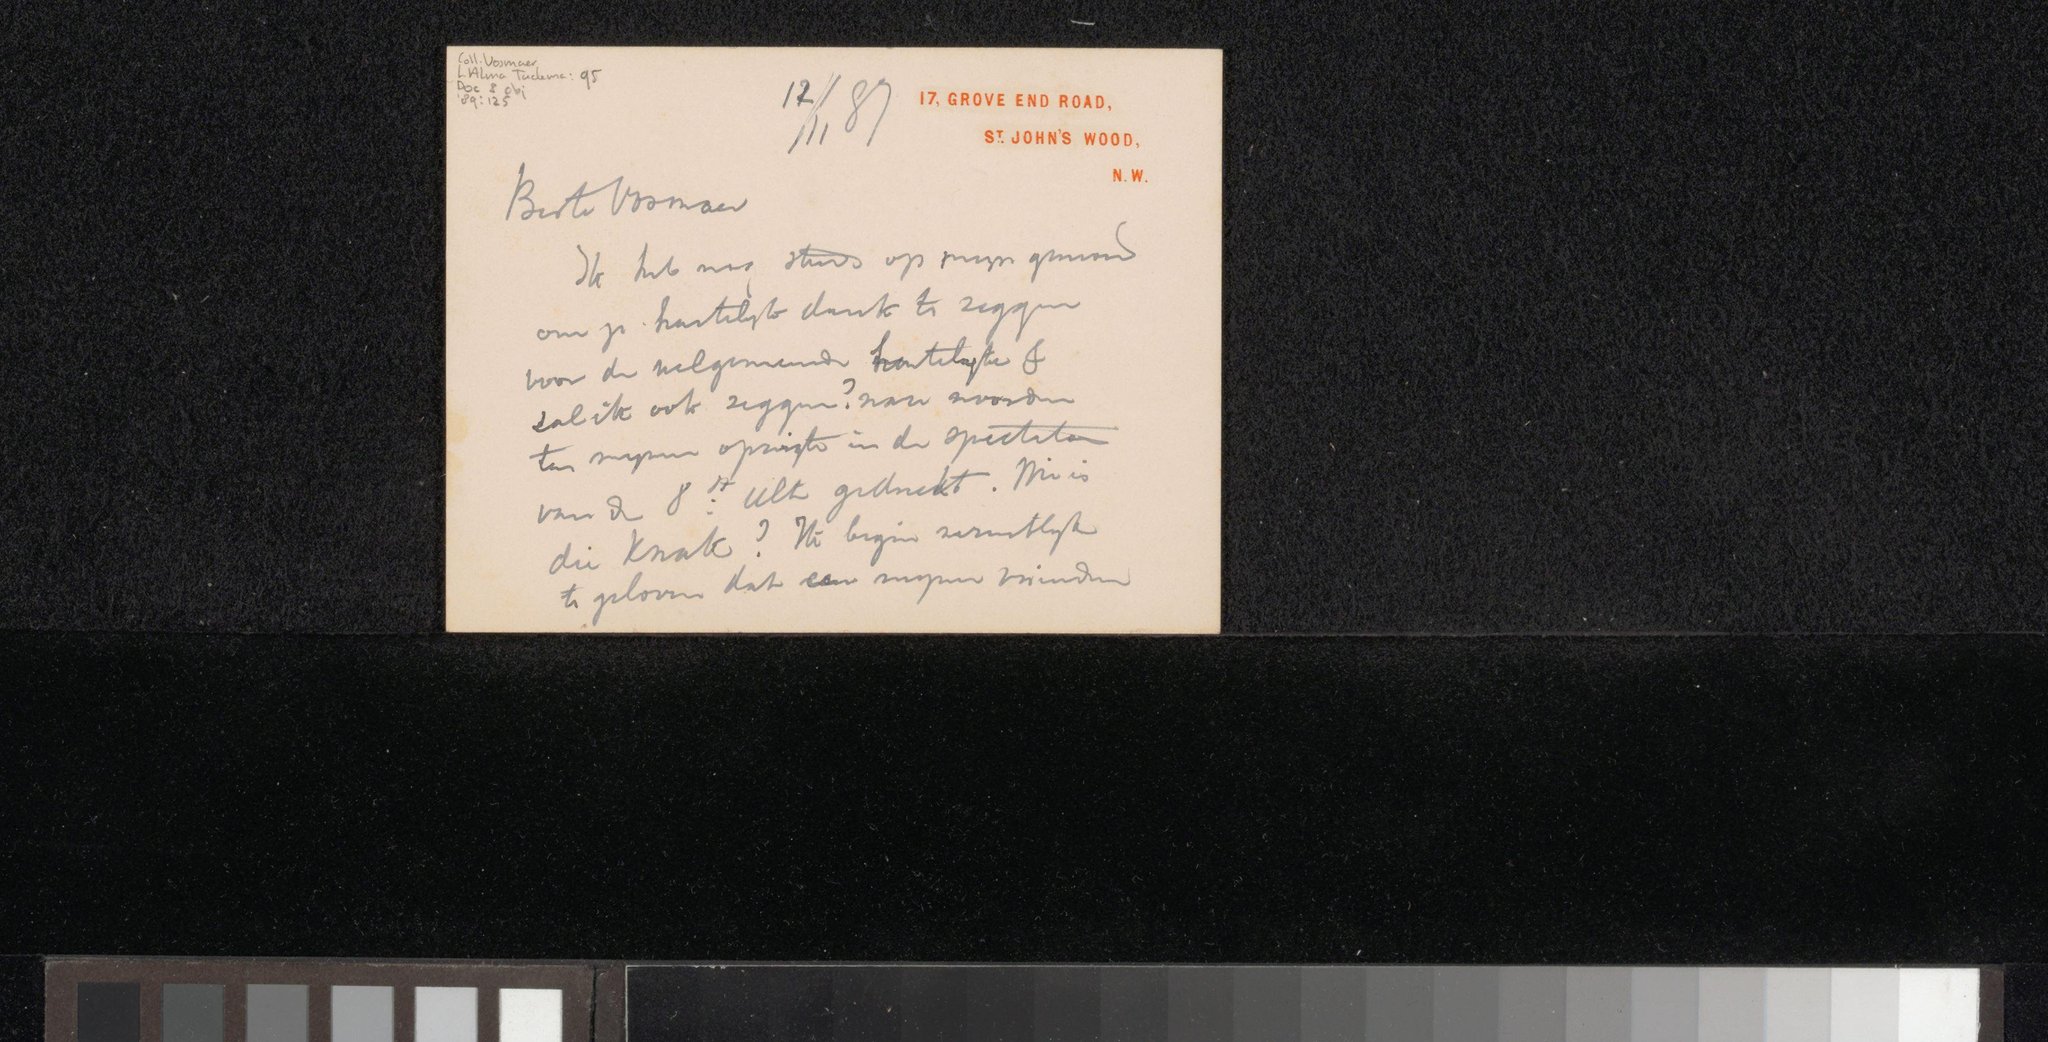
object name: letter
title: Brief aan Carel Vosmaer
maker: lourens alma tadema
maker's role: draughtsman, print maker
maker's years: 1836-1912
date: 1887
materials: cardboard, ink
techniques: pen, printing, writing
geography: london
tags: the hague, print maker, draughtsman, carel vosmaer